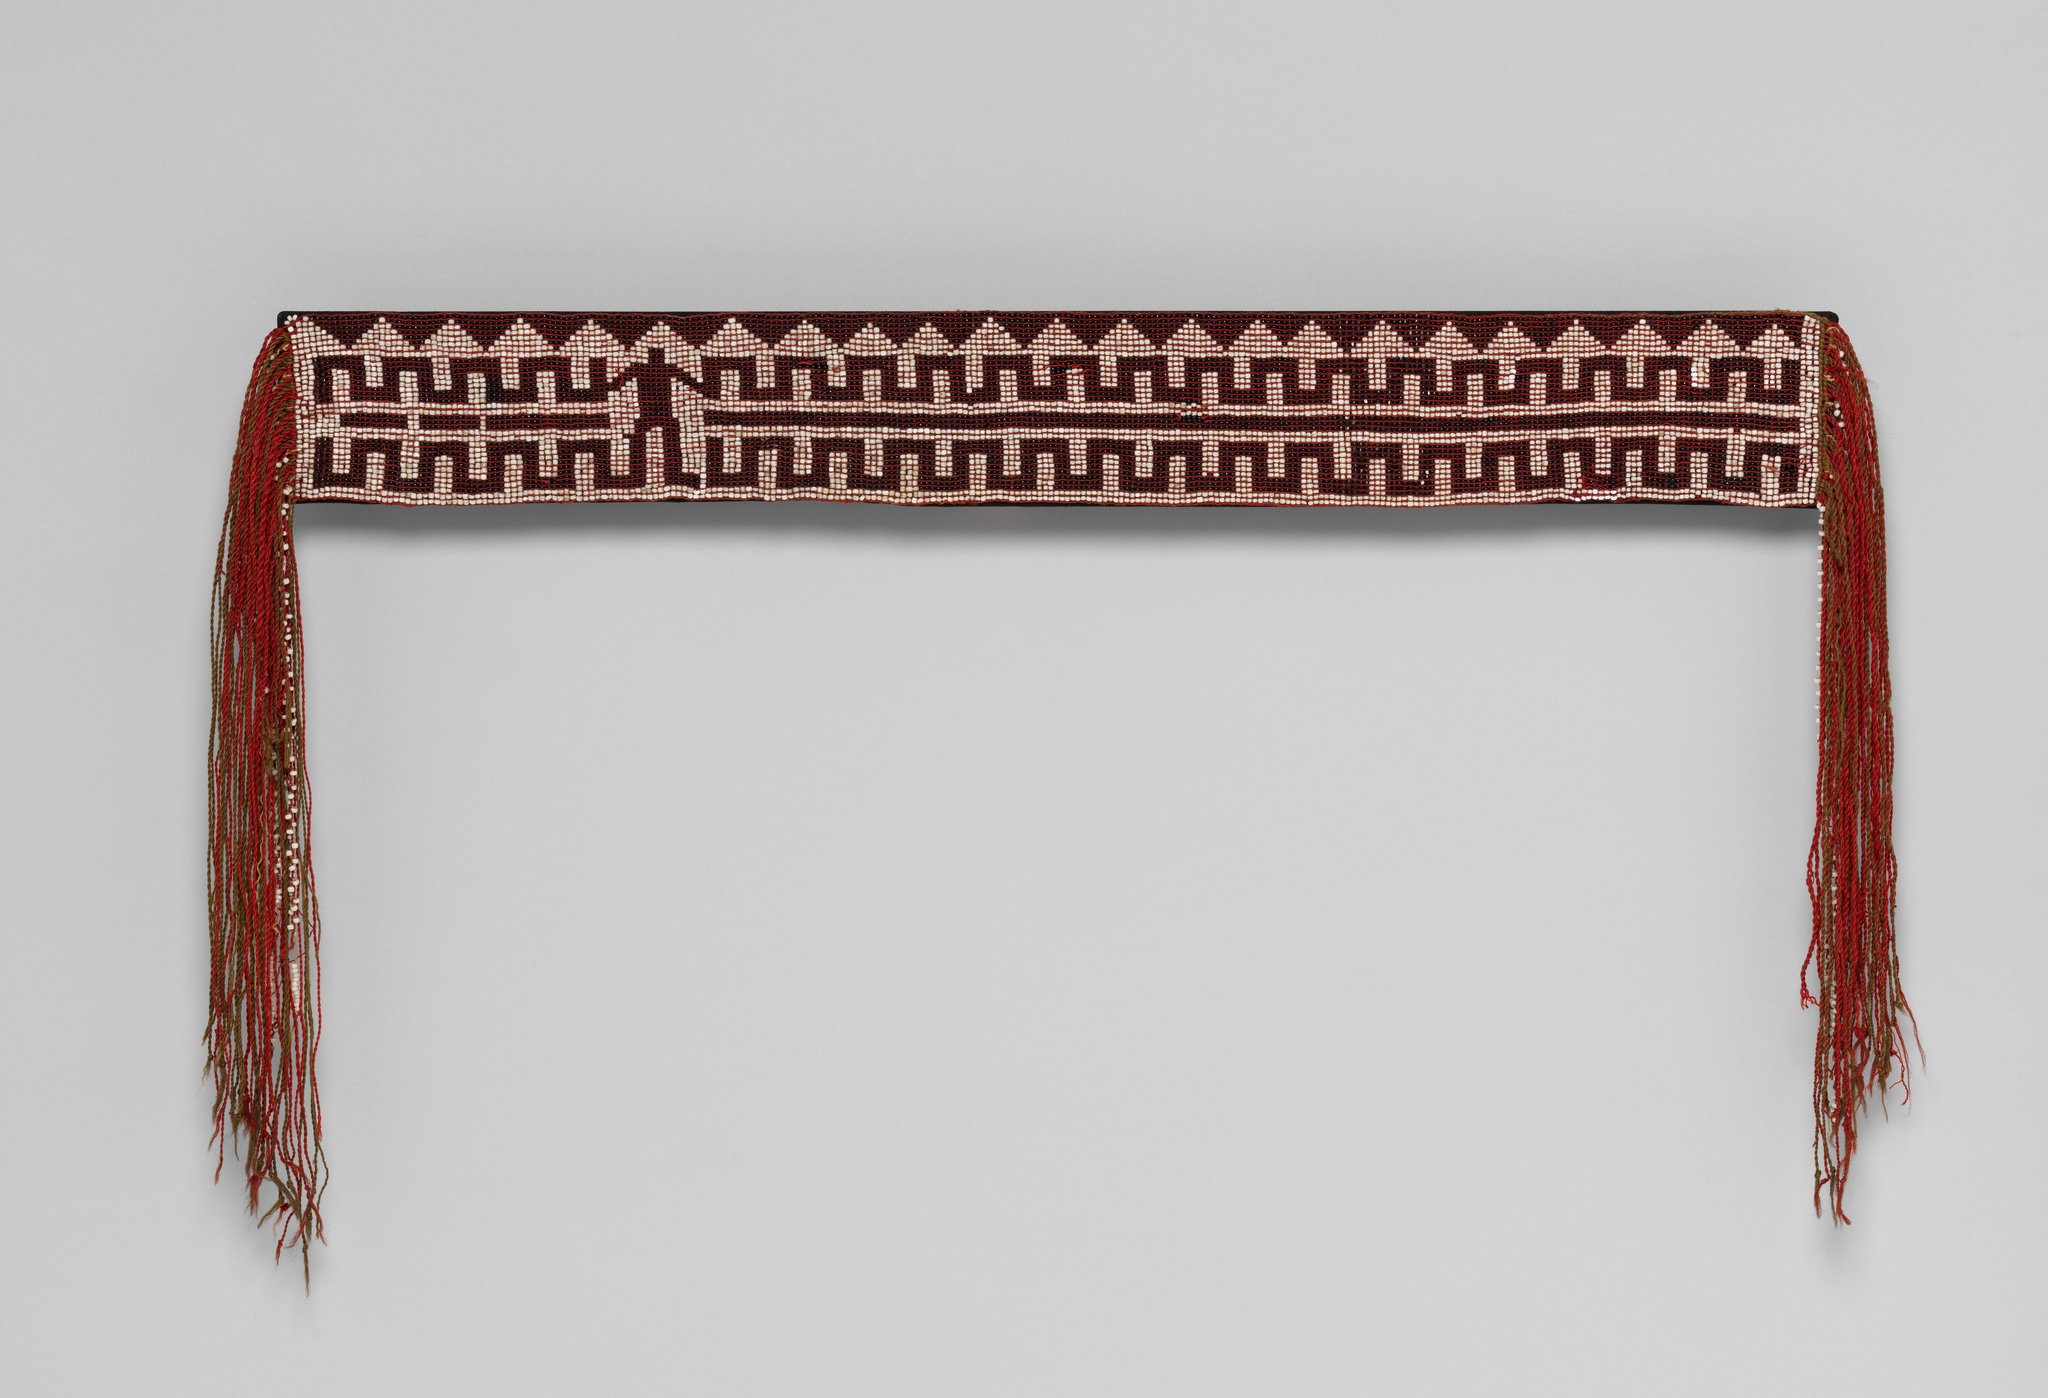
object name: sash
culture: western great lakes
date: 1800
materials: glass, wool, thread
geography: canada